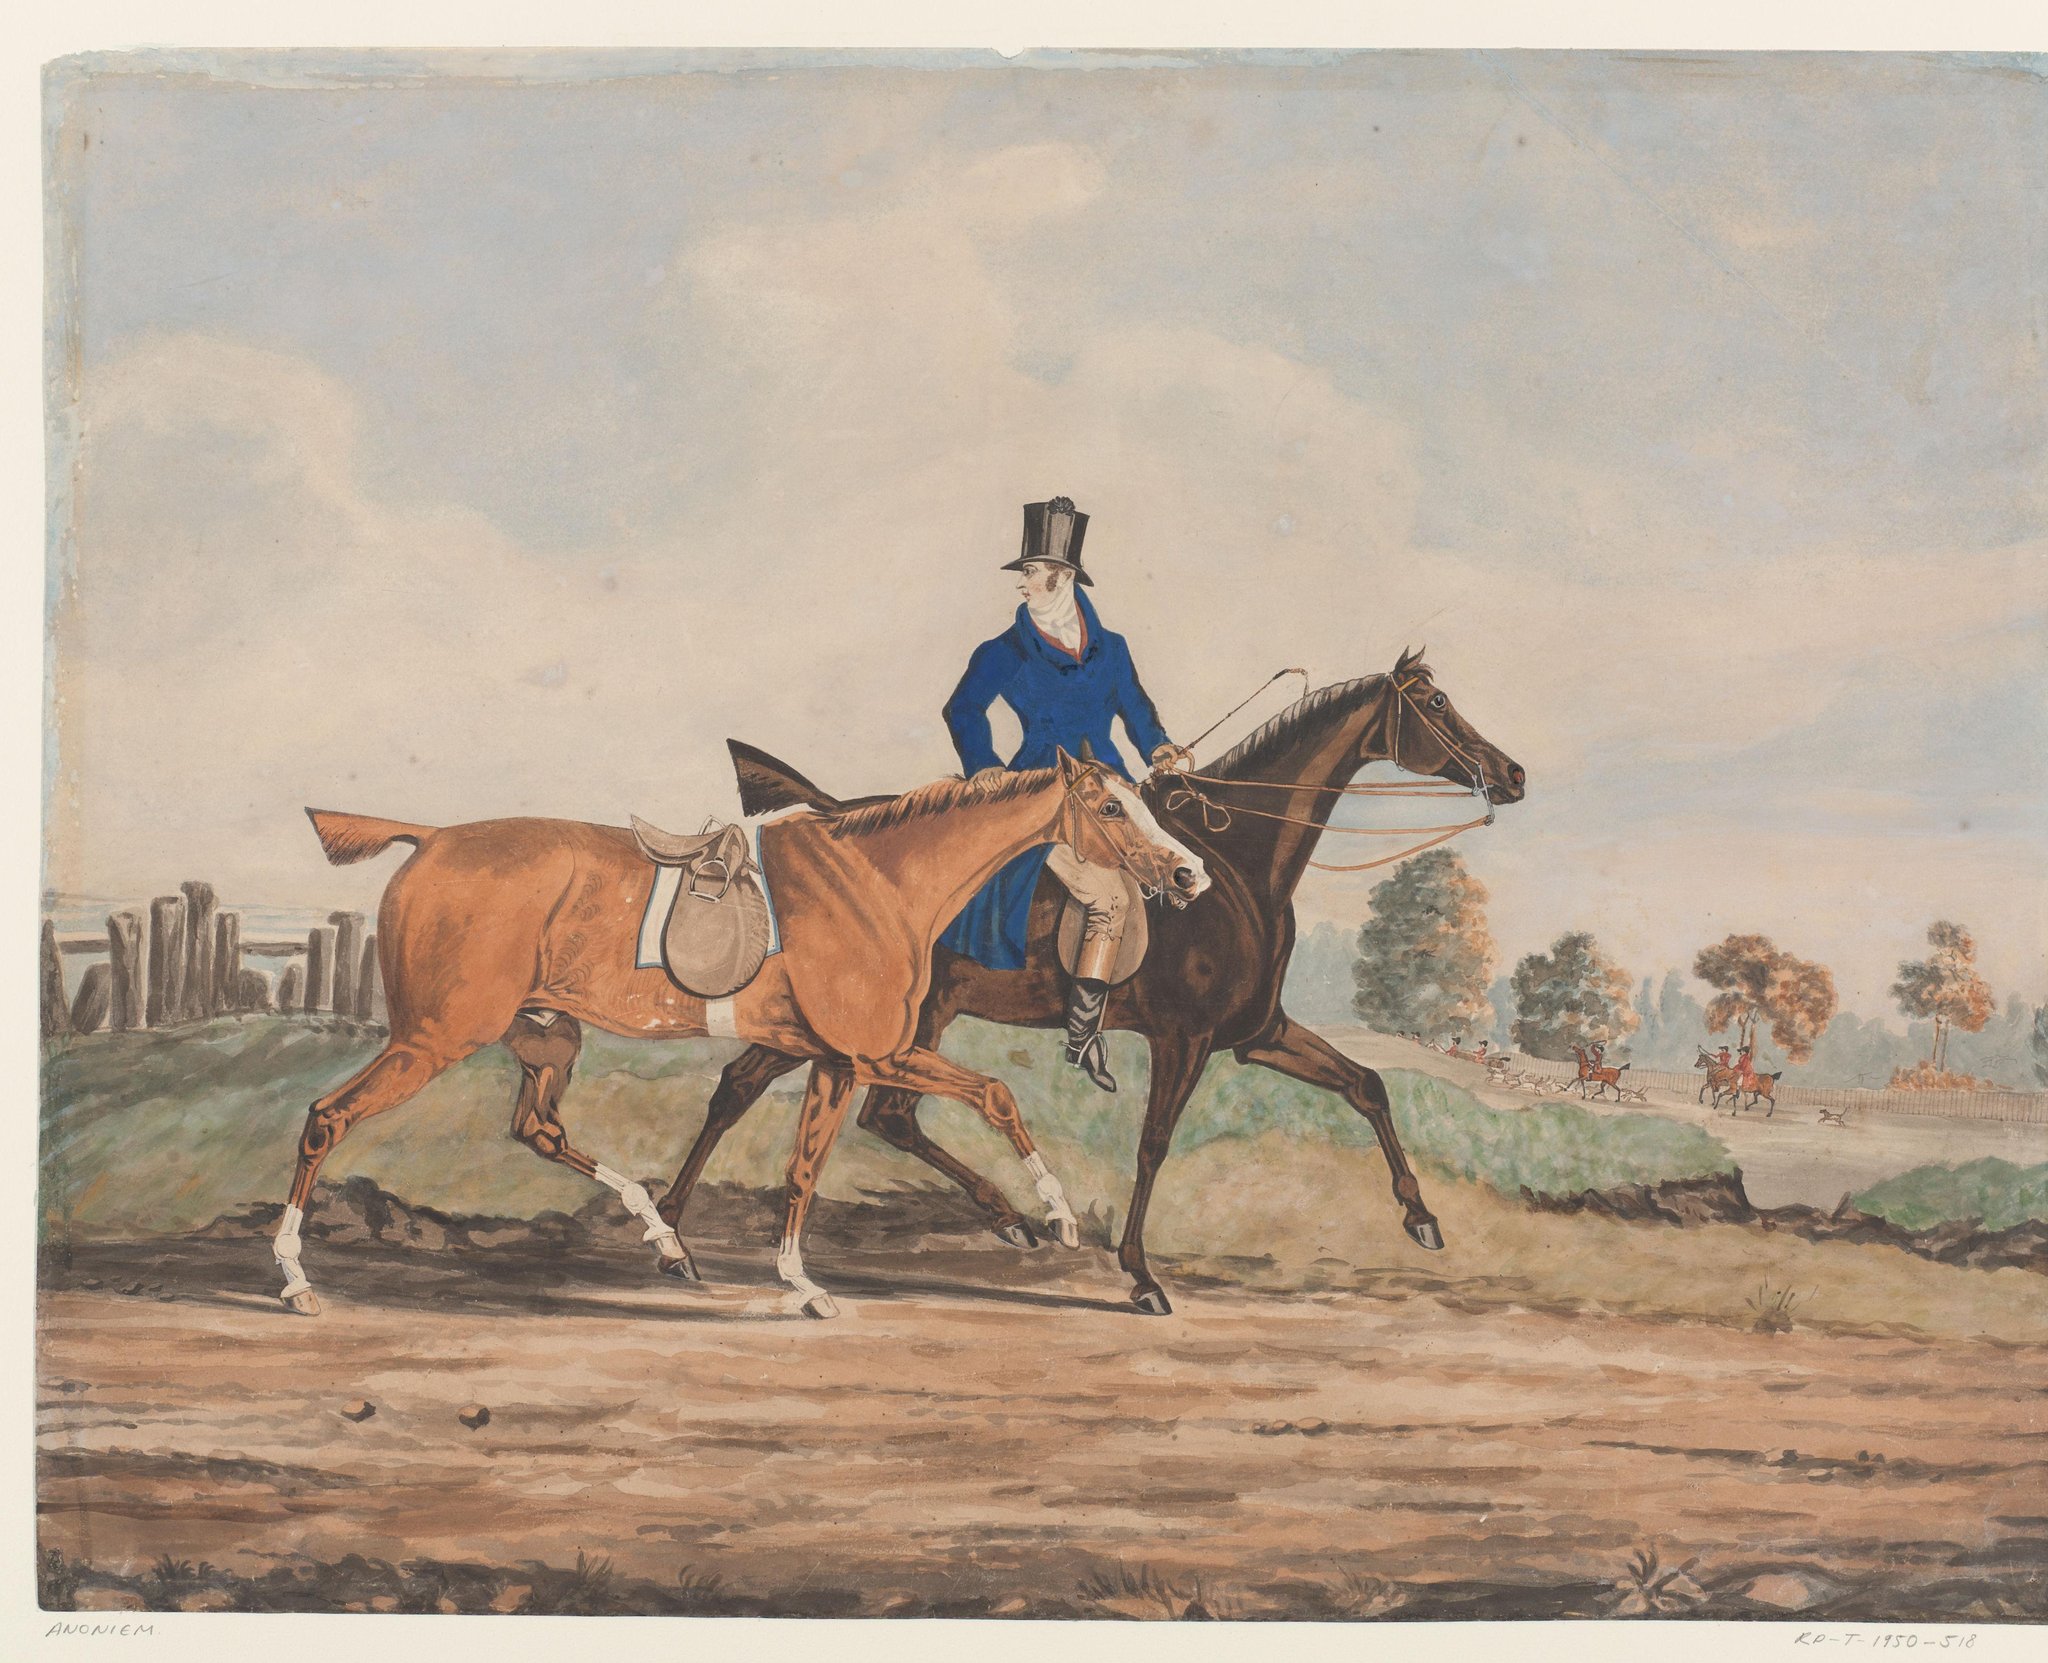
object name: drawing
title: Heerrijden met twee renpaarden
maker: Anonymous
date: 1800-1900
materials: paint, paper, watercolor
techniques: brush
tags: horse-racing, training of horses